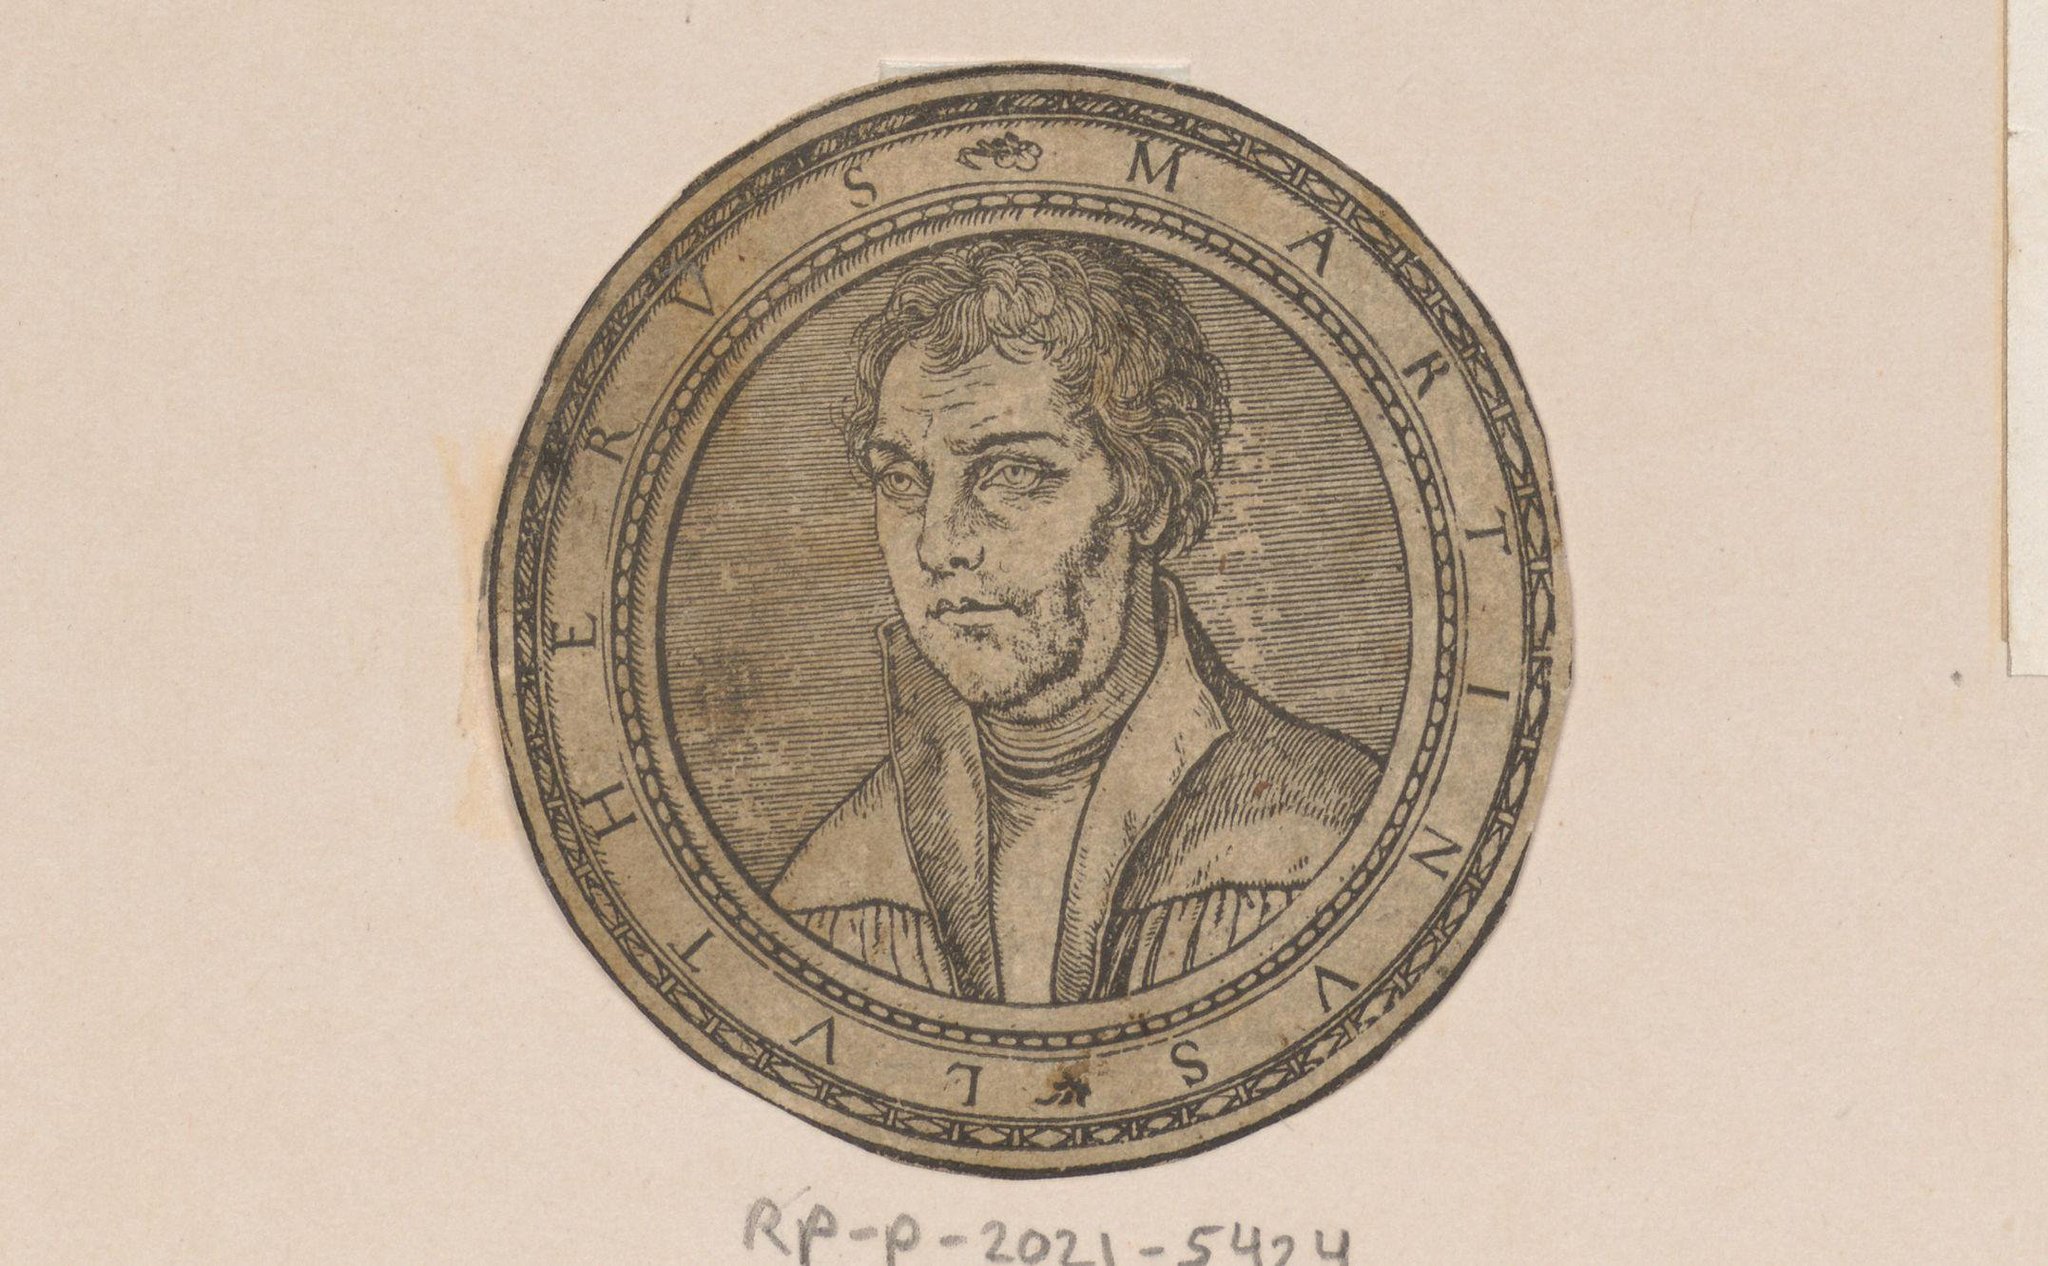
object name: print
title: Portret van Martin Luther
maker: Anonymous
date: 1550-1630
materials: paper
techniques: woodcut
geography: germany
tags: priest, martin luther, theologian, historical persons